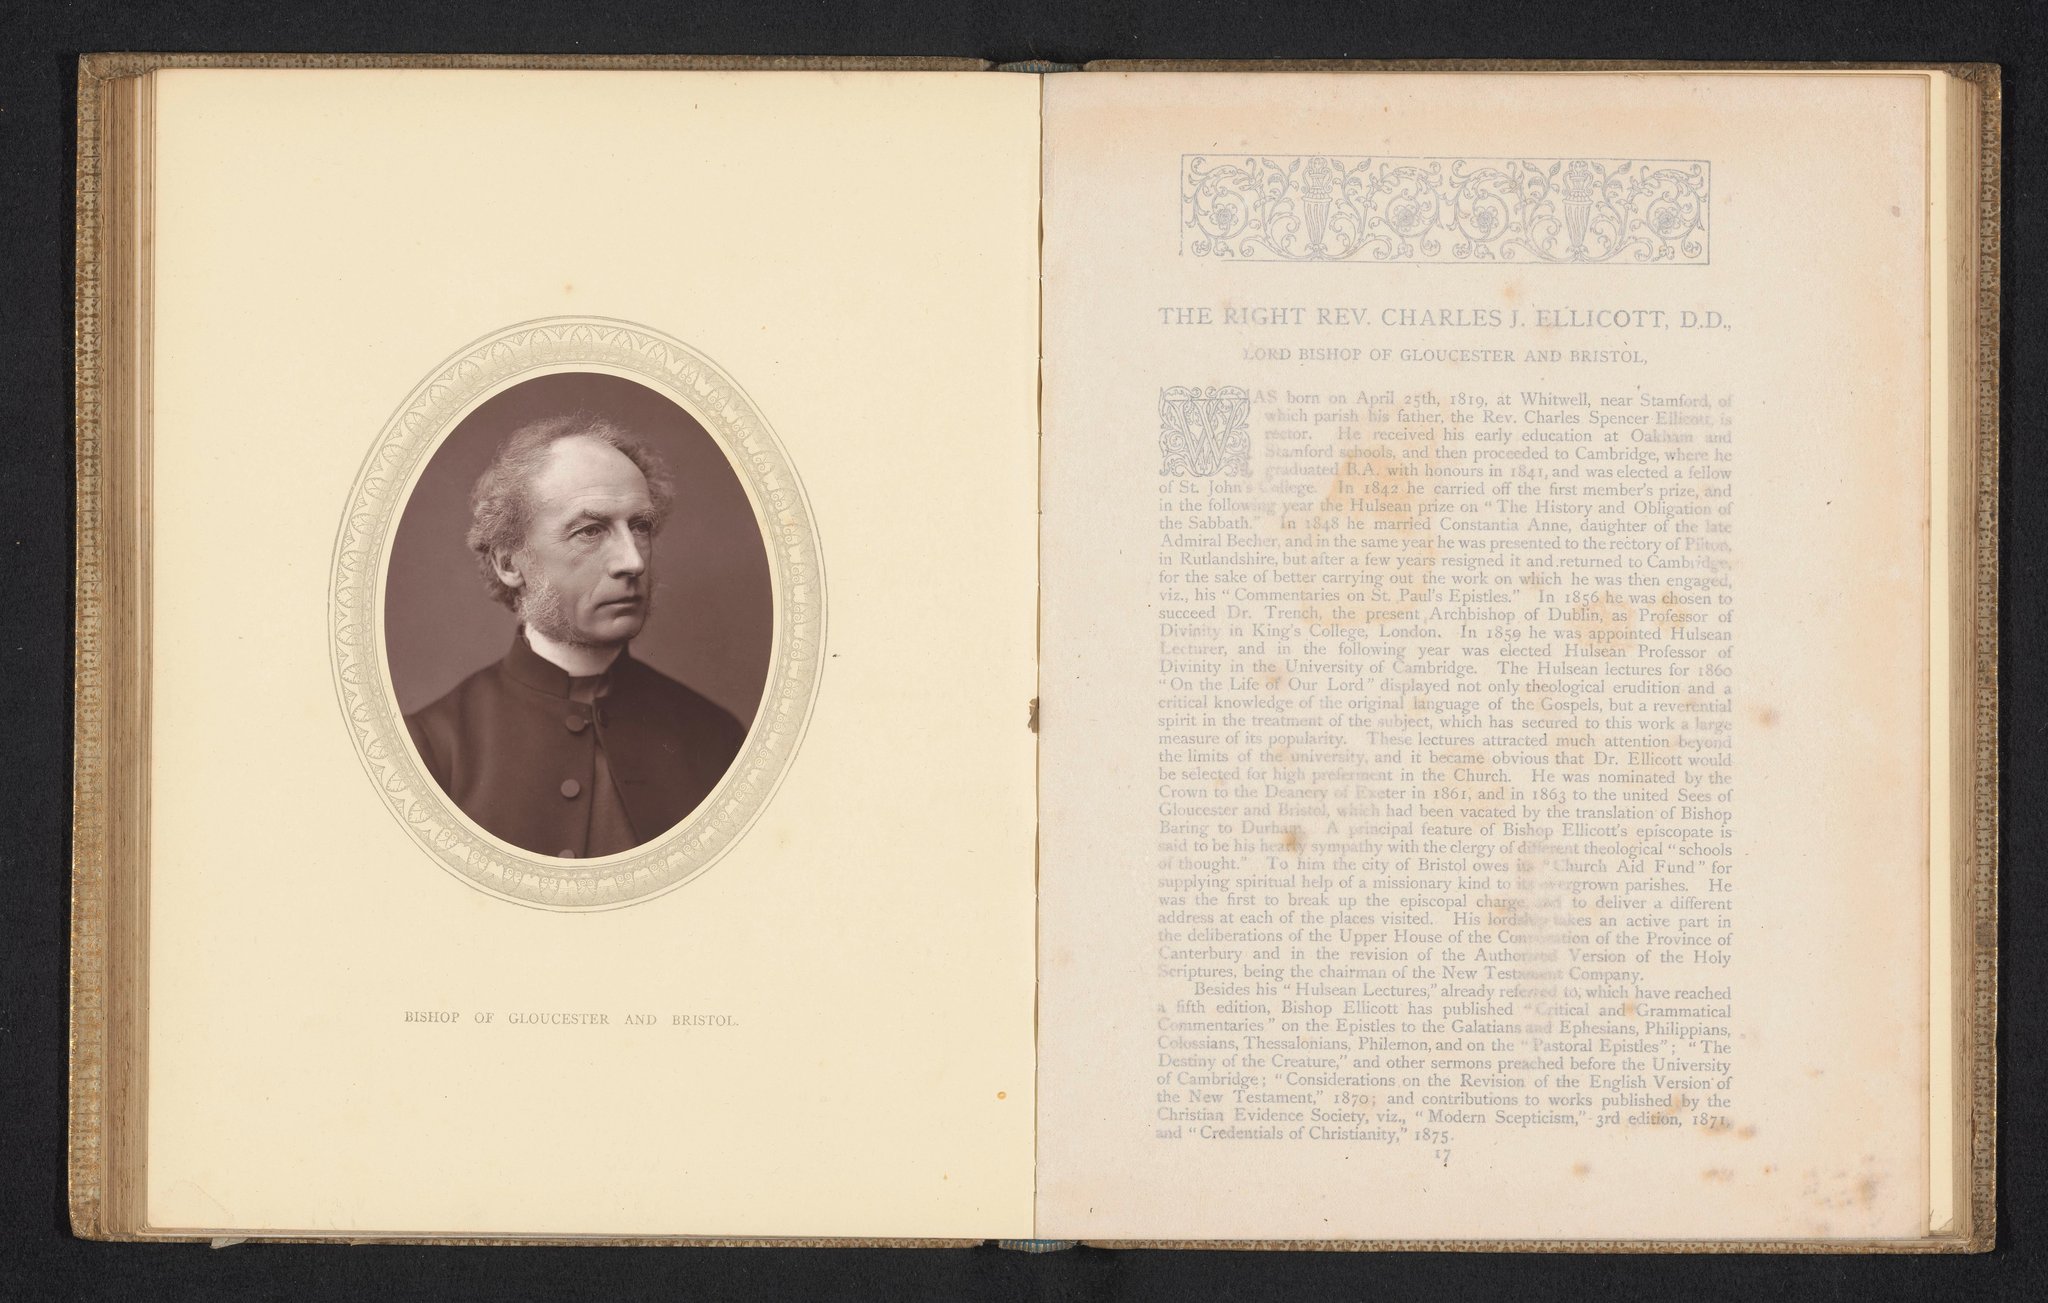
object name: photomechanical print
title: Bishop of Gloucester and Bristol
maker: Anonymous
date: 1871-1876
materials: paper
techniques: woodburytype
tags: functionaries and dignitaries ~ episcopal protestant churches, historical persons (portraits and scenes from the life) (+ (full) bust portrait)